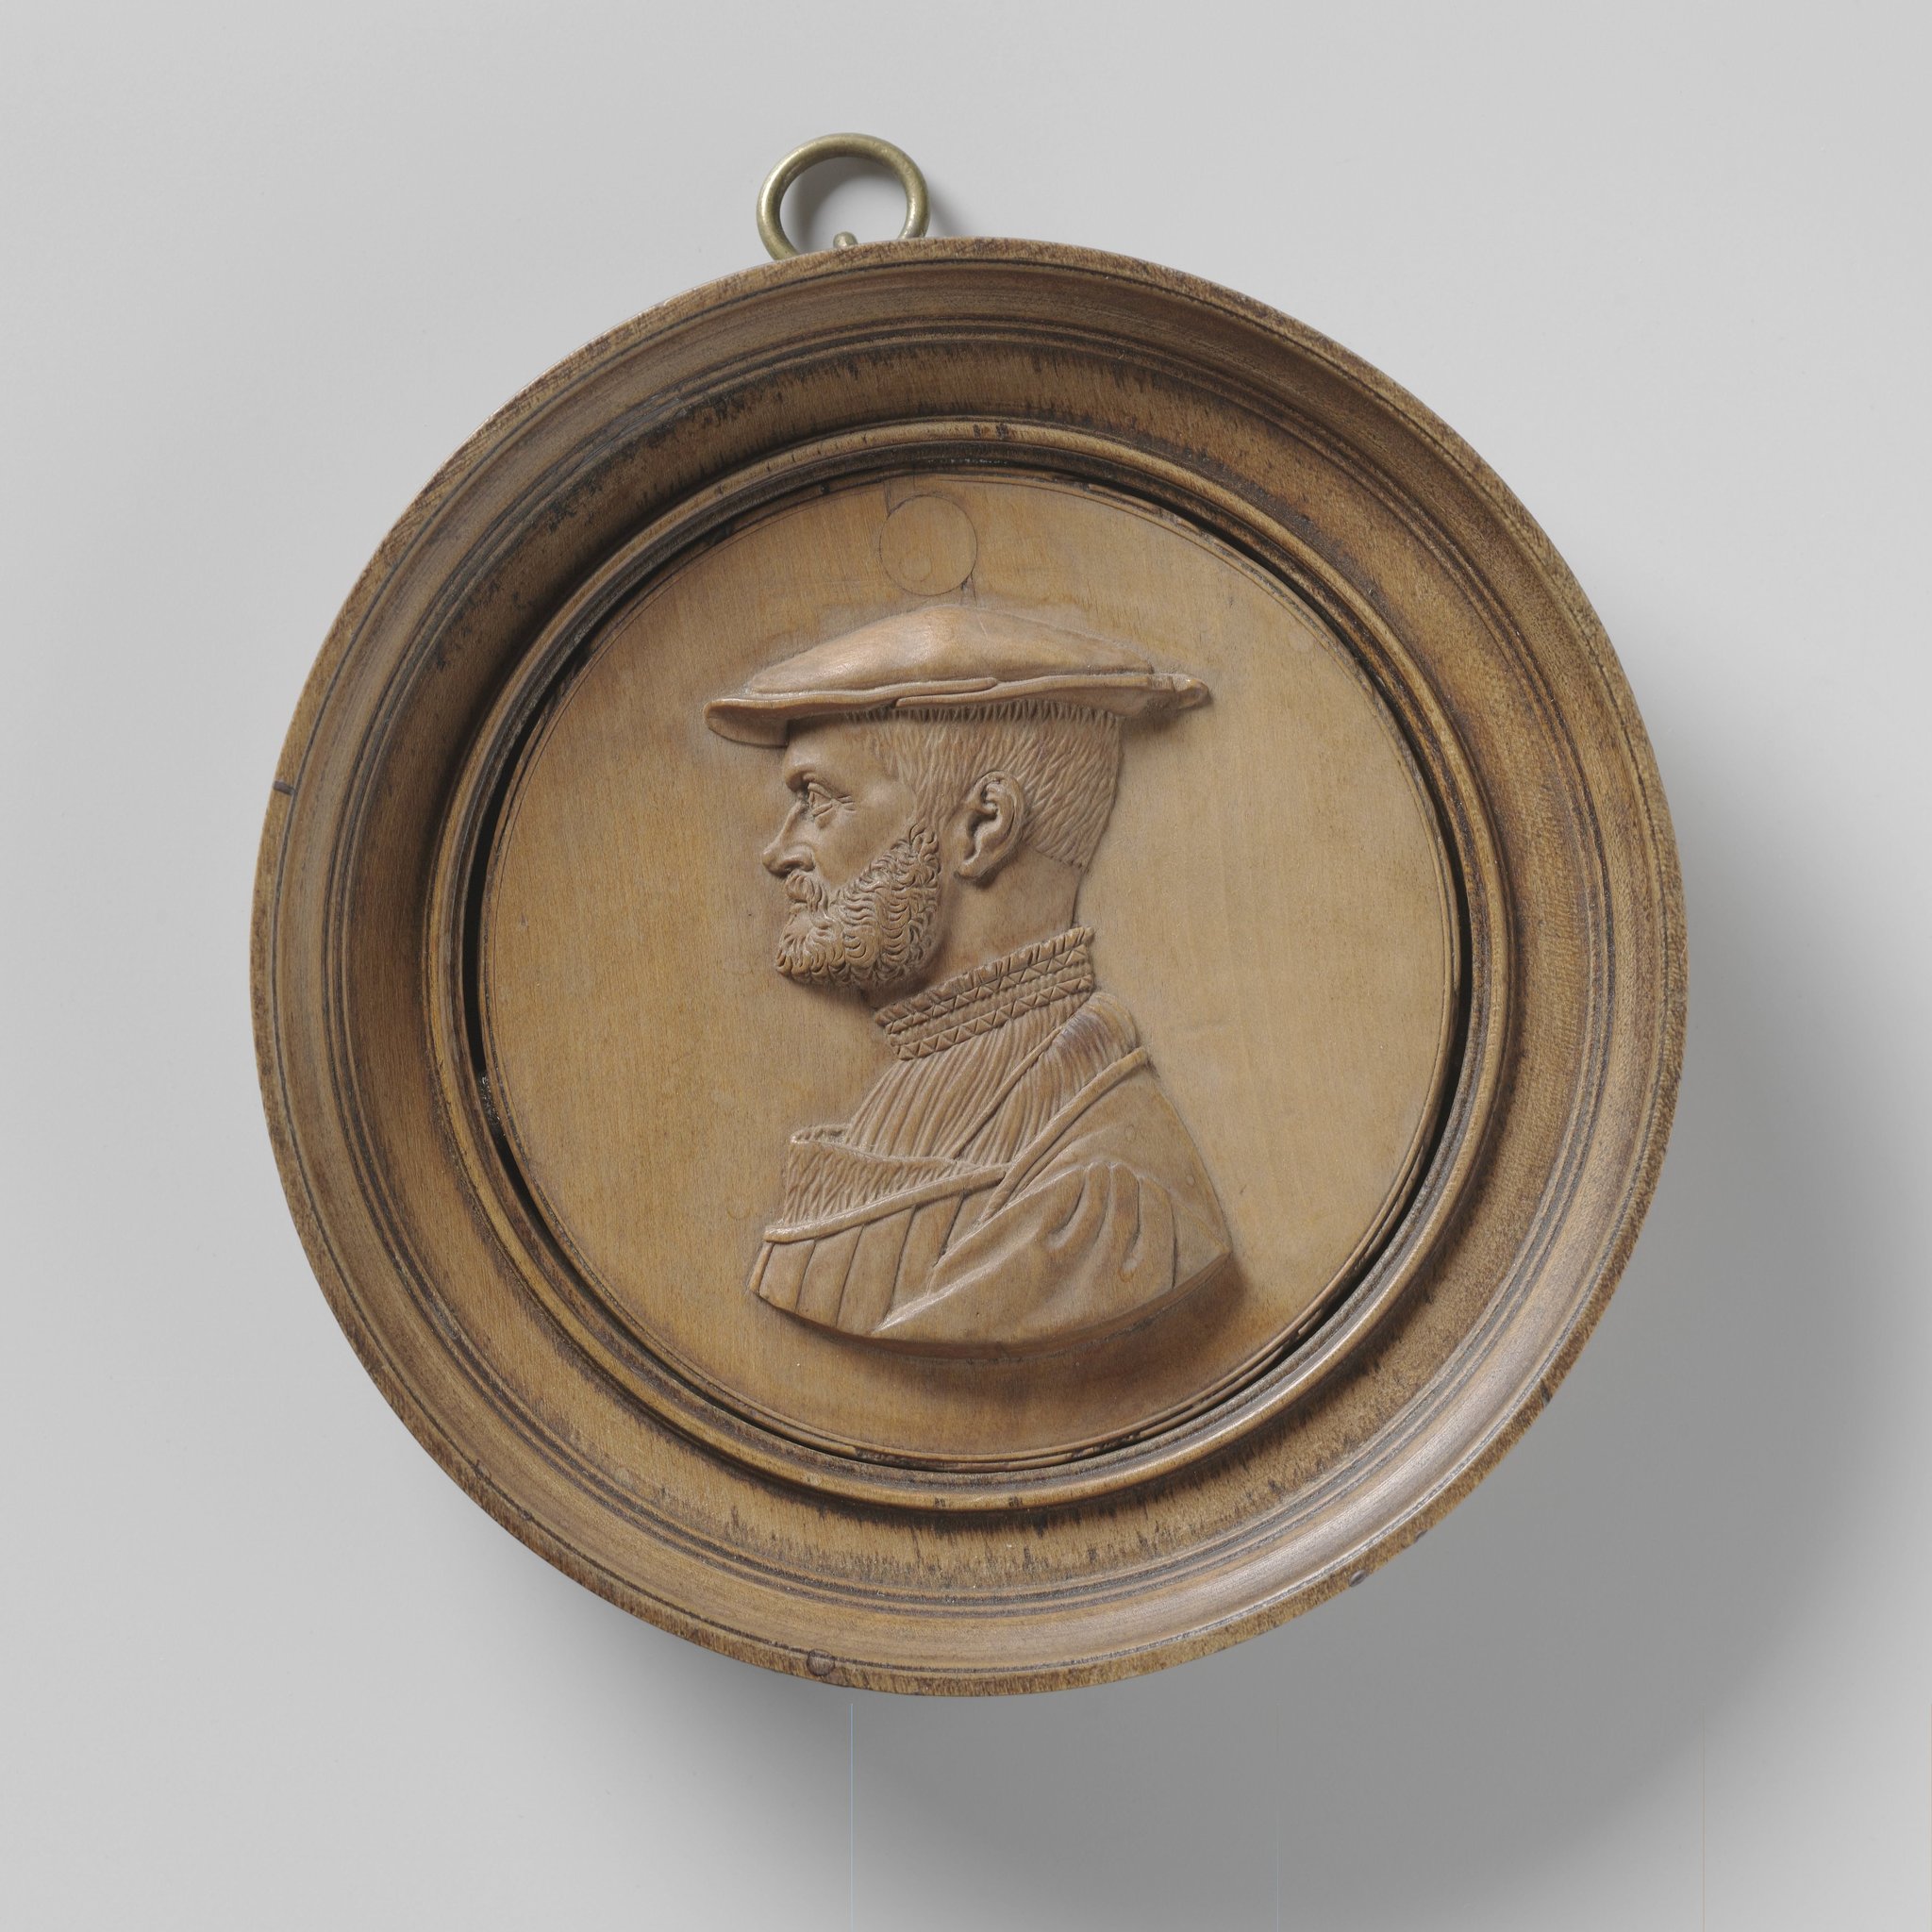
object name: portretmedaillon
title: Portretmedaillon van een man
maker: friedrich hagenauer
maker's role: medailleur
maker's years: 1499-1546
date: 1530-1532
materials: wood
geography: augsburg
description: Friedrich Hagenauer (1490/1500-after 1546. Portrait medallion of a man. Palmwood and walnut. Germany, c. 1530-1540.